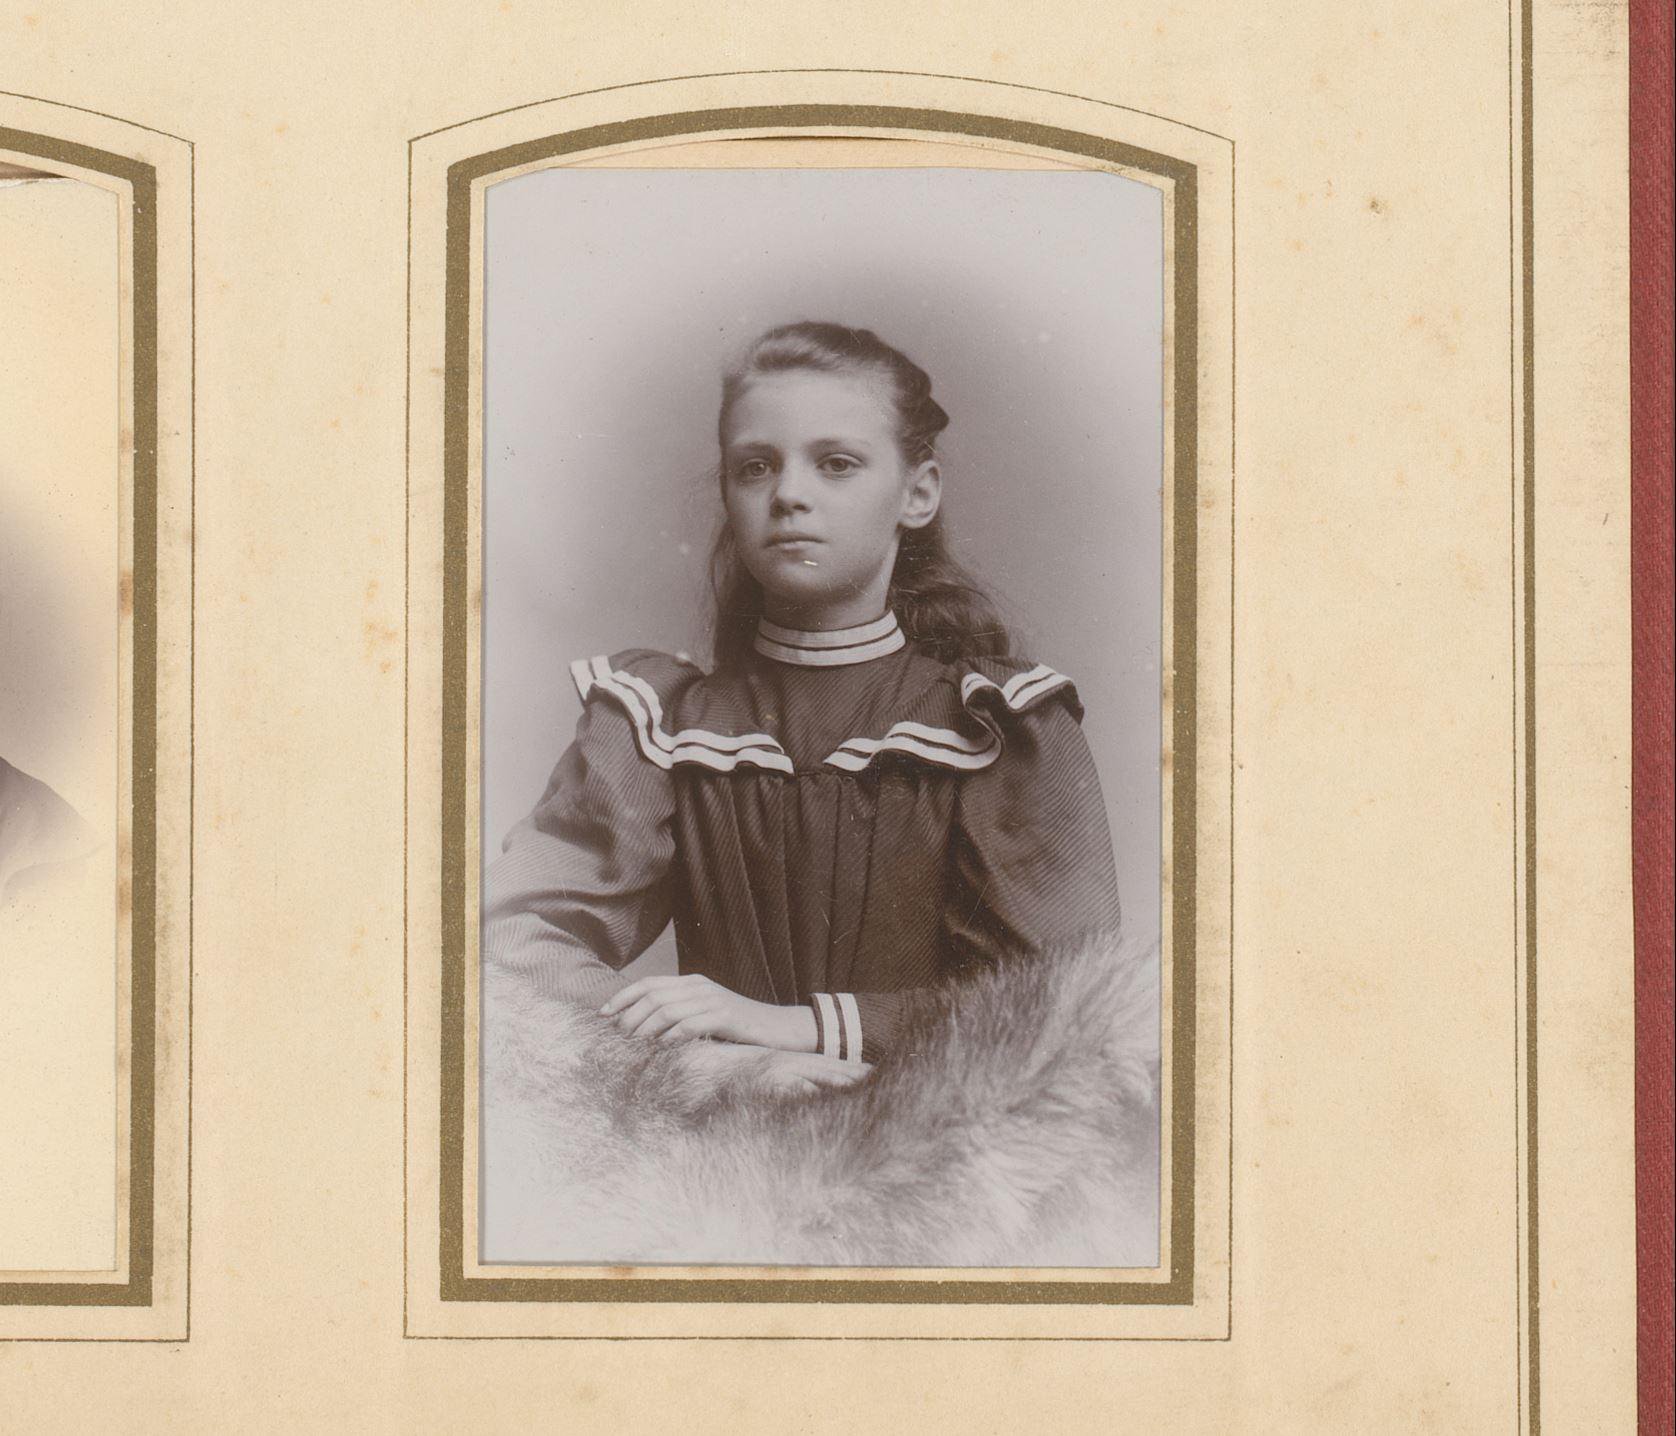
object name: photograph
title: Portret van een meisje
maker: willem bernard bekkering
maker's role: painter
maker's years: 1858-1902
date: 1886-1902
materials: cardboard, photographic support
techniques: collodion silver print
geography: groningen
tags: historical persons - bb - woman, girl (child between toddler and youth)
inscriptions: inscription: ‘W. B. Bekkering/ Firma Godfried de Jong/ Groningen/ Heerestraat/ hoek kl. pelsterstr.’